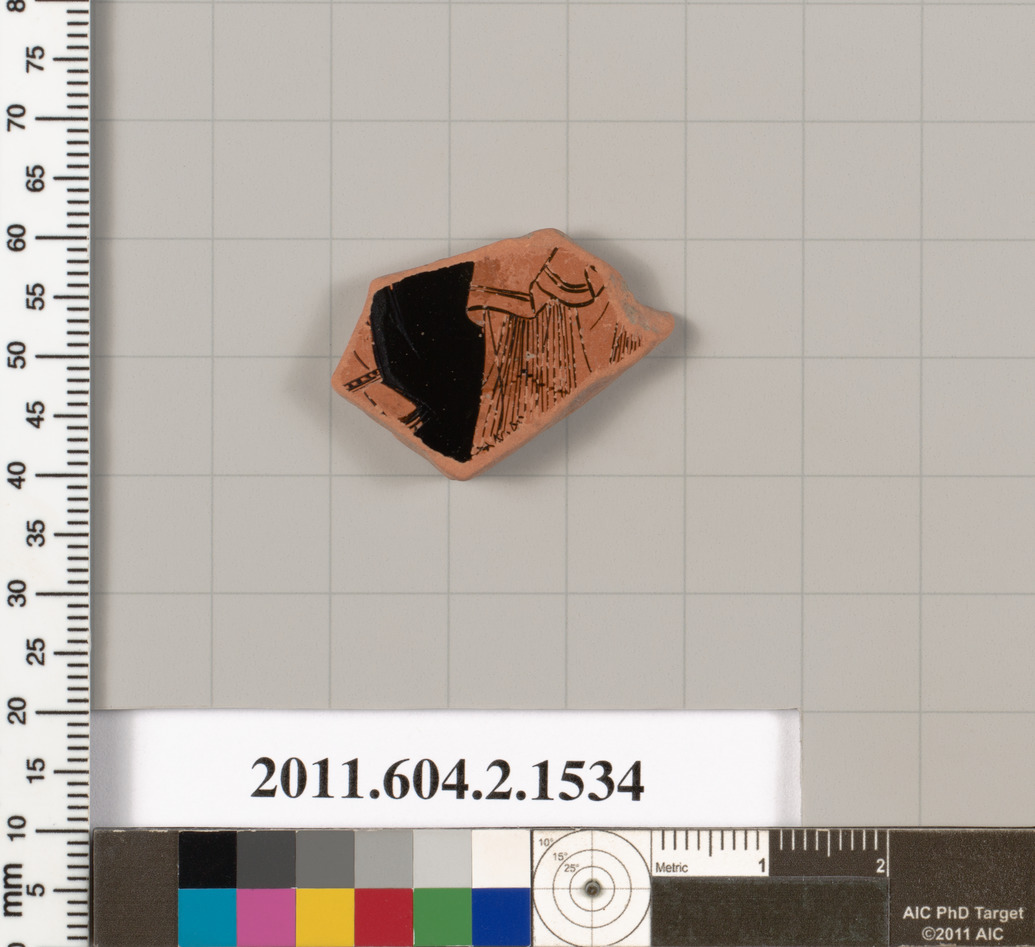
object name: skyphos fragment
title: Terracotta fragment of a skyphos (deep drinking cup)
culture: greek, attic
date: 490-480 BCE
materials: terracotta